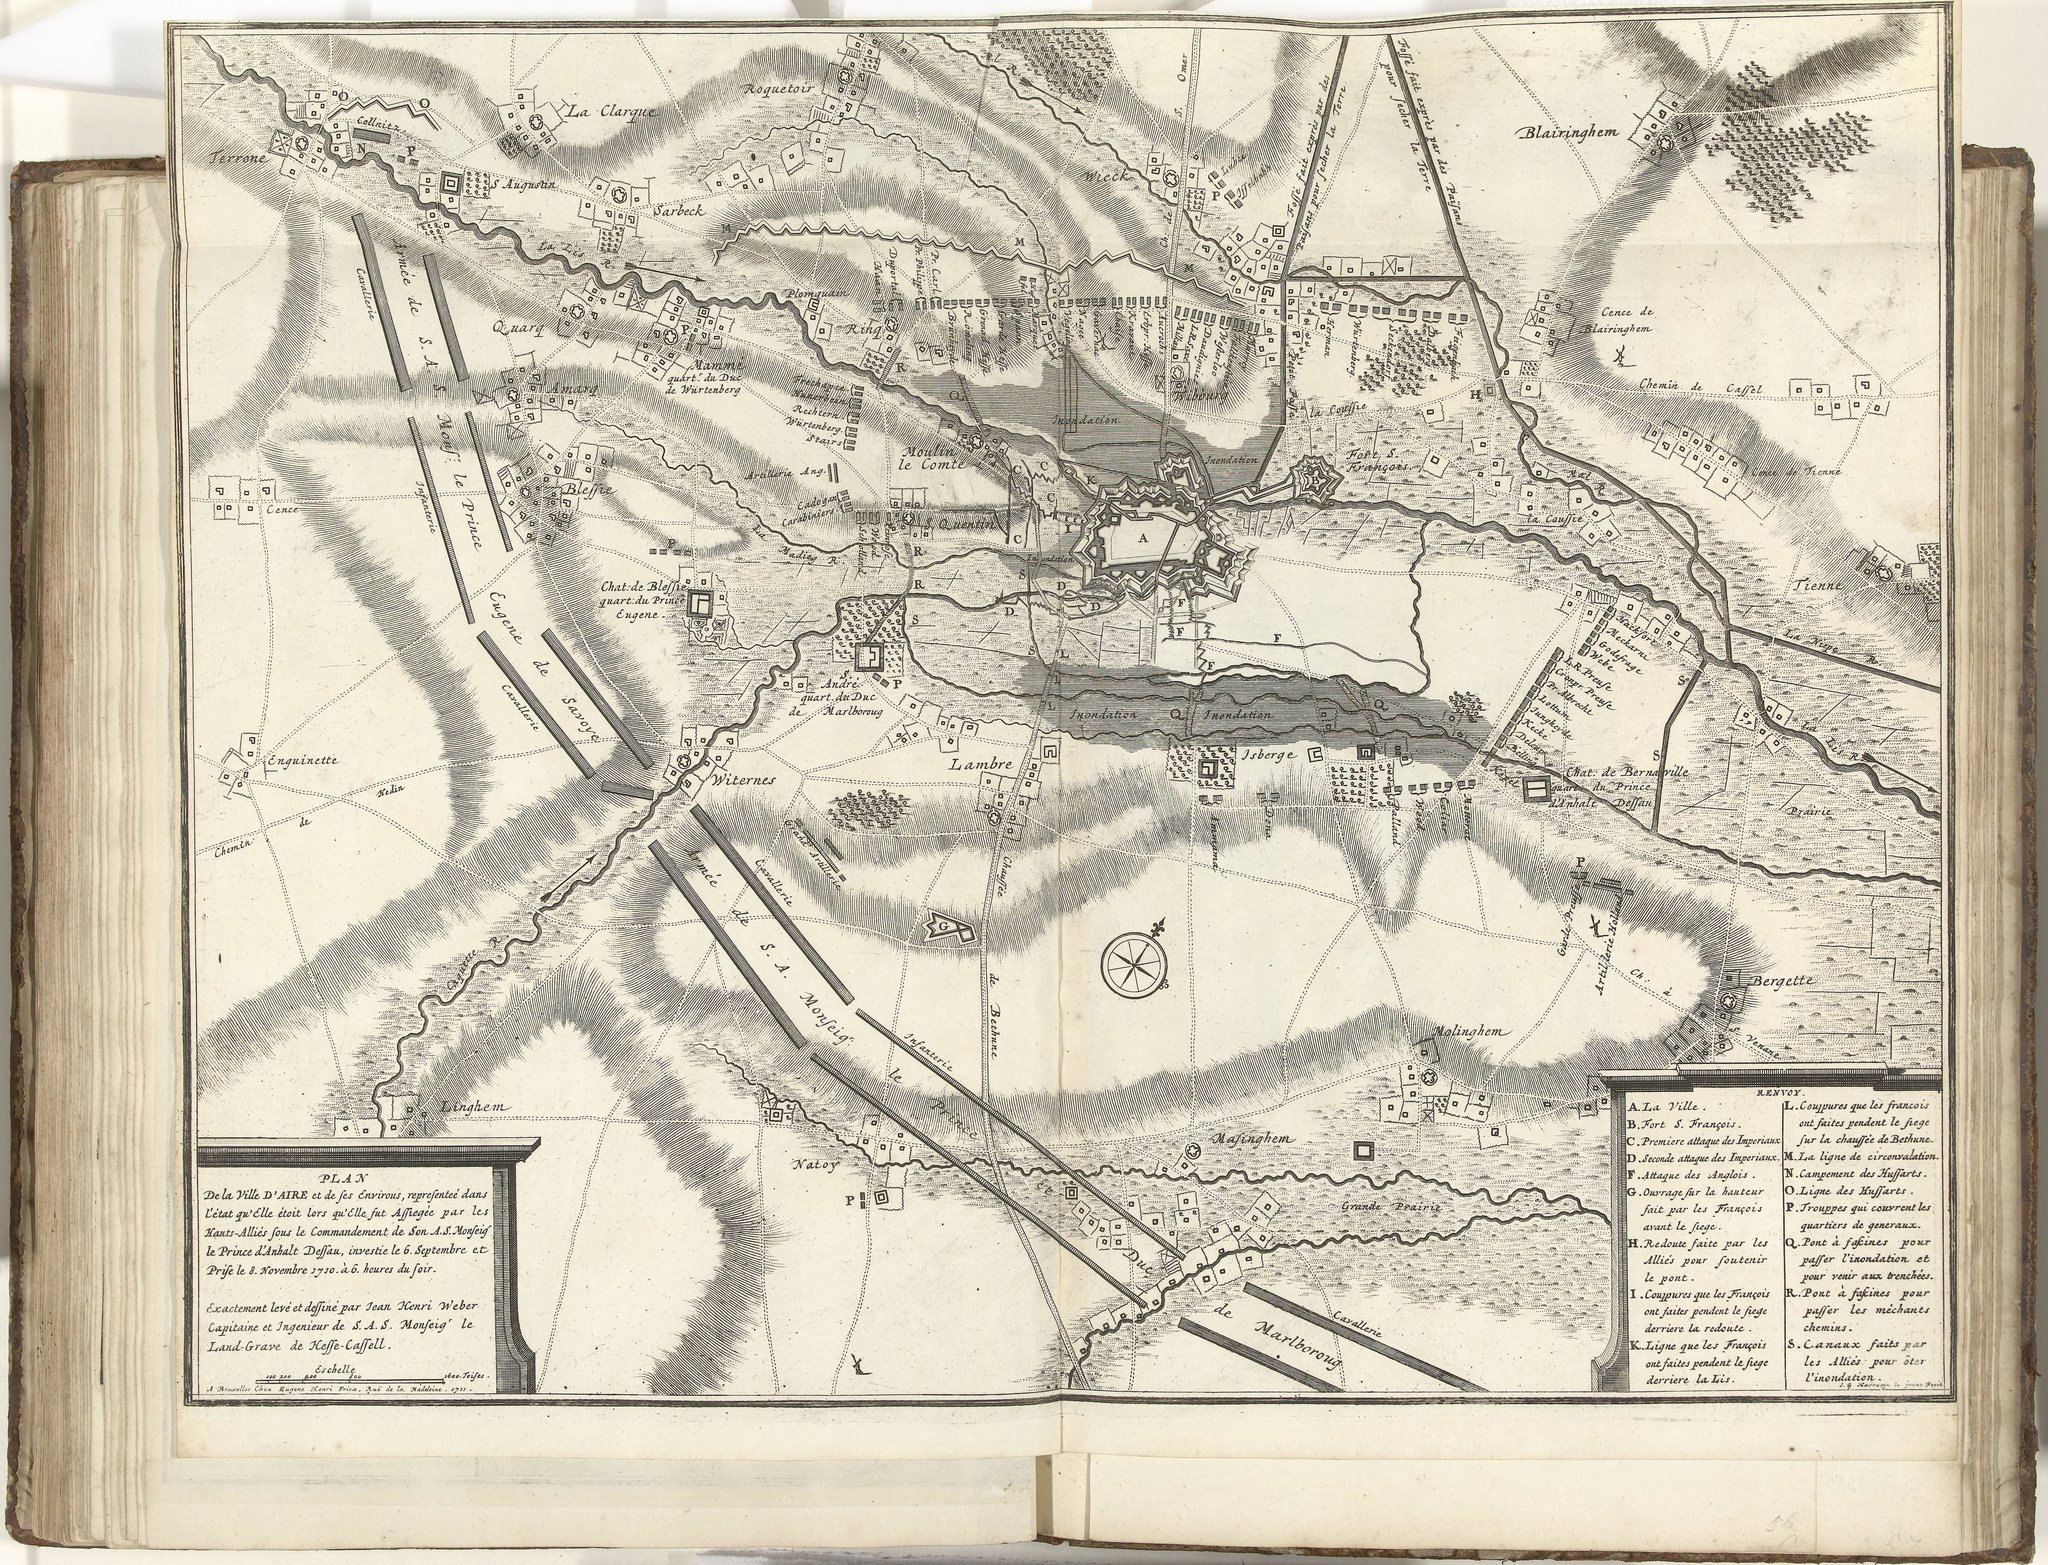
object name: print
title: Beleg van Aire, 1710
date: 1711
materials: paper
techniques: engraving, etching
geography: brussels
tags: maps of separate countries or regions, siege, position war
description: Kaart van het beleg van de stad Aire met de wijde omgeving, belegerd vanaf 11 september en ingenomen door de Geallieerden onder de vorst van Anhalt-Dessau op 8 november 1710. Rechtsonder een cartouche met de legenda A-S in het Frans. Onderdeel van een gebundelde verzameling van plannen van veldslagen en steden vermaard in de Spaanse Successieoorlog.